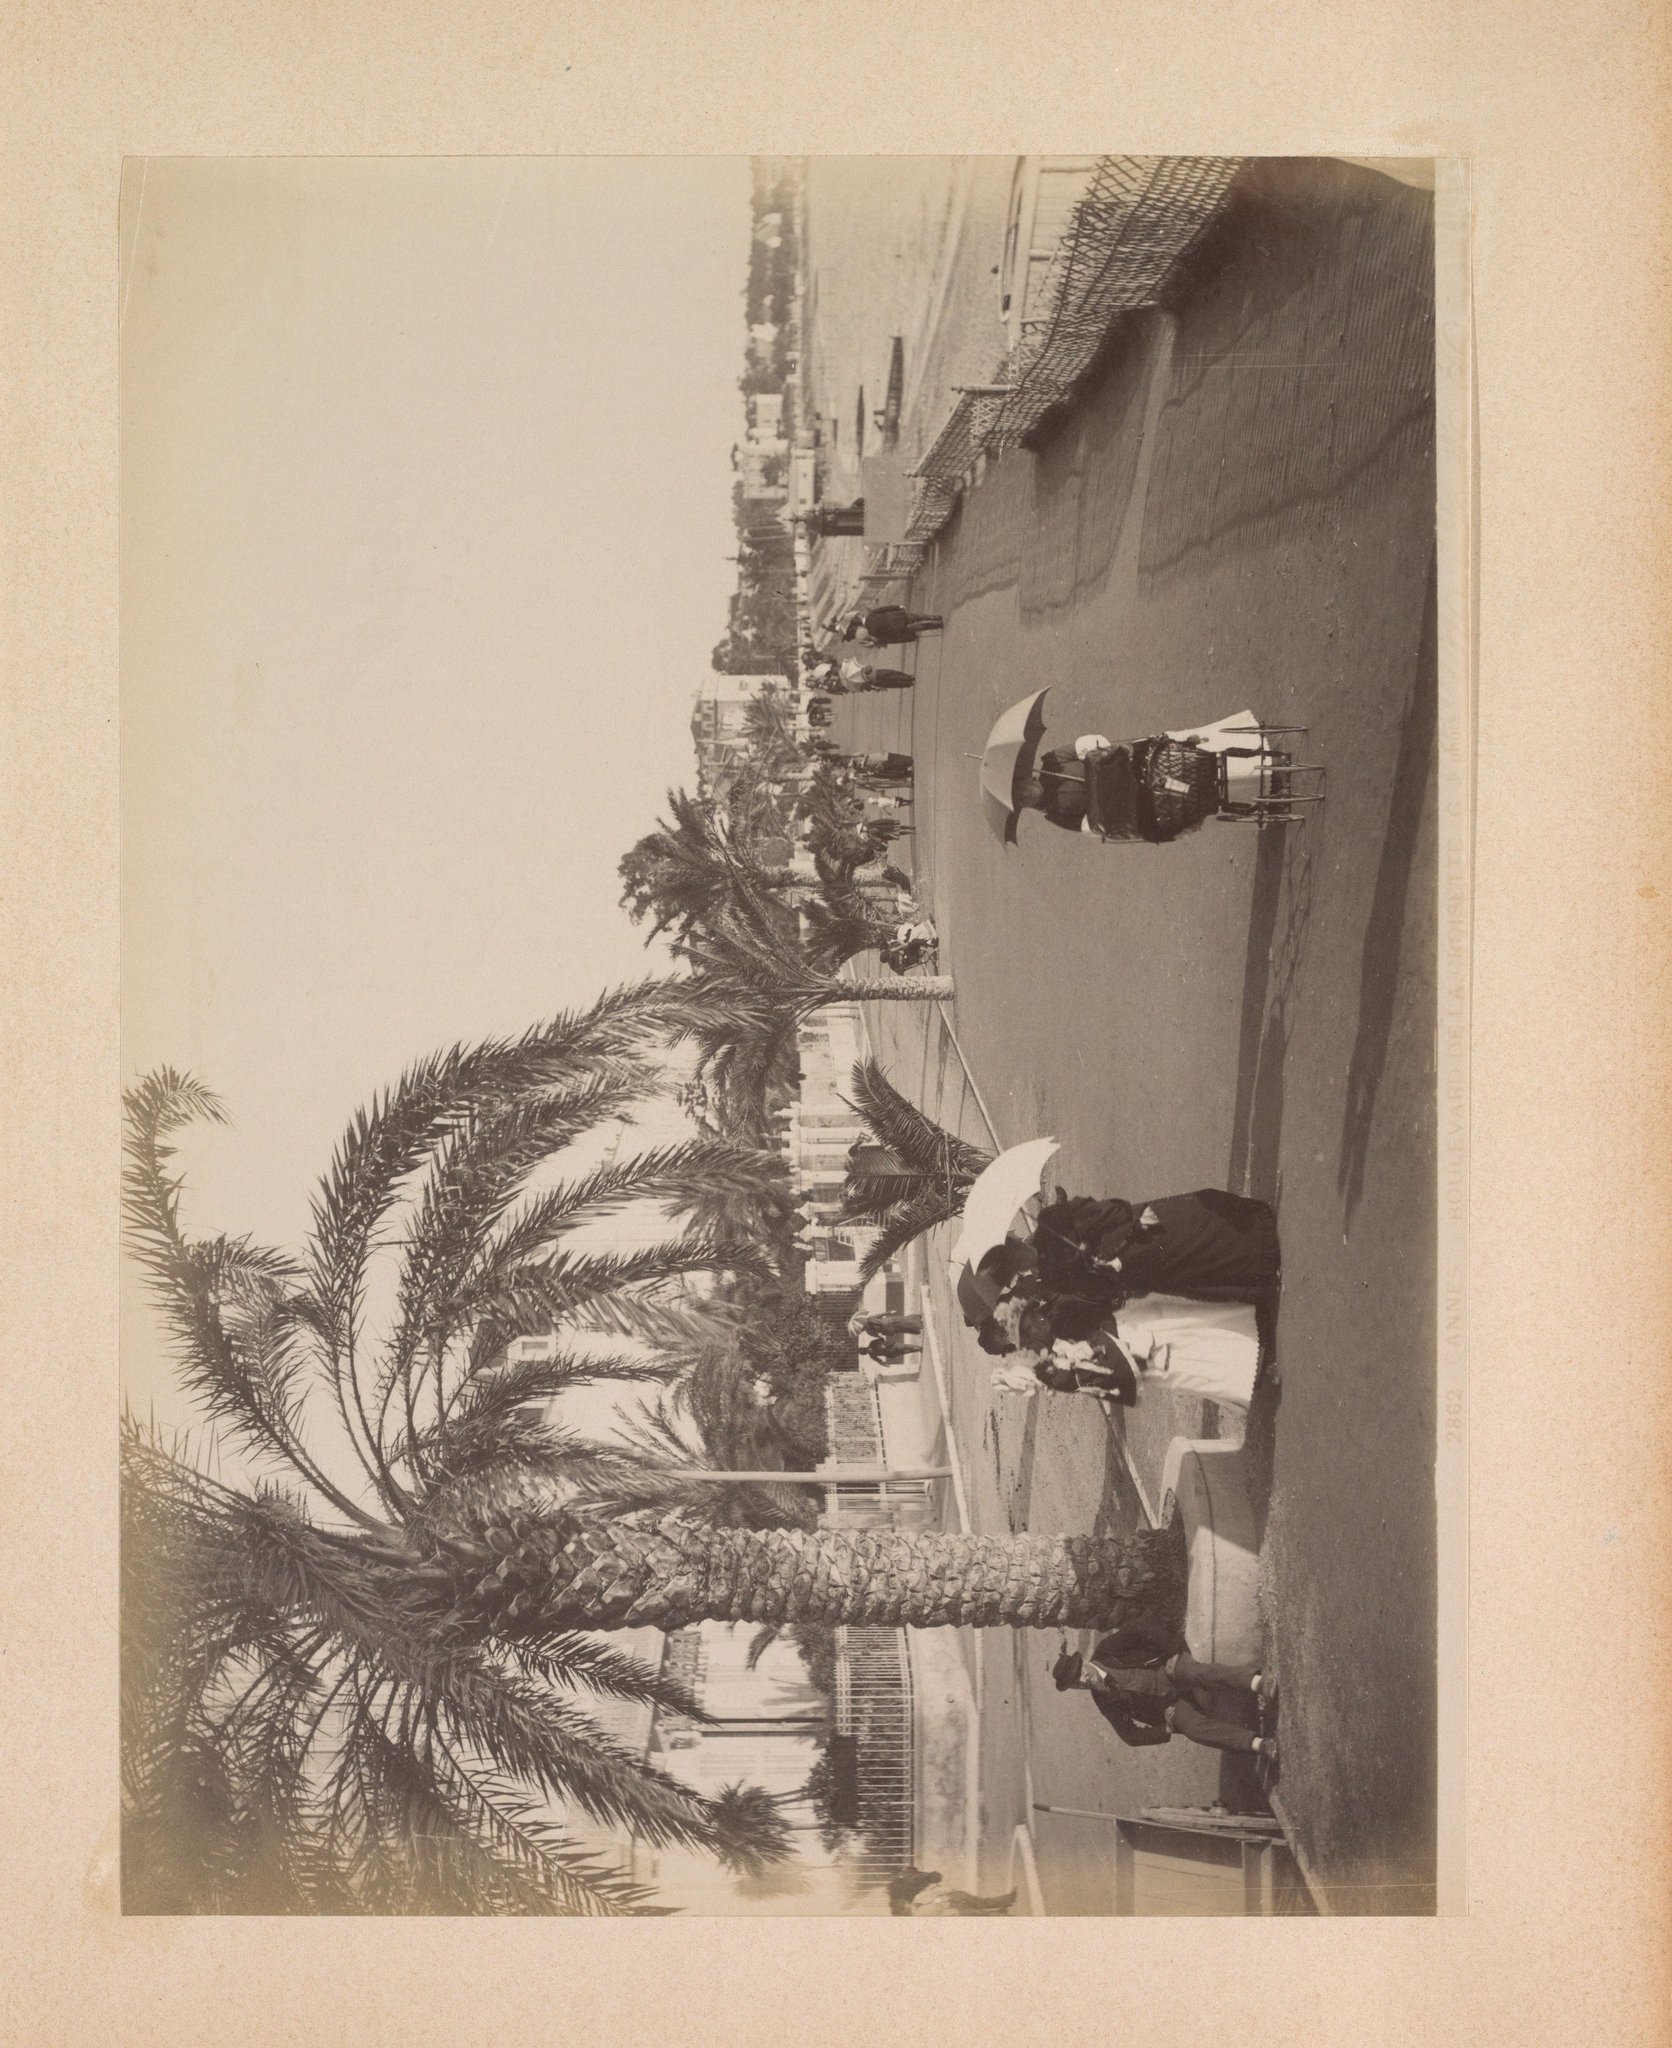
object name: album leaf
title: Flanerende mensen op de Boulevard de la Croisette in Cannes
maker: jean gilletta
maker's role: fotograaf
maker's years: 1856-1933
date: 1870-1900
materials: paper, photographic support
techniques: albumen print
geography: cannes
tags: baby-carriage, pram, perambulator, strolling, avenue, boulevard, promenade, esplanade (+ city(-scape) with figures, staffage), trees: palm-tree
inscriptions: negative number: ‘2862’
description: Onderdeel van Reisalbum met foto's van bezienswaardigheden in Italië en Zuid-Frankrijk.